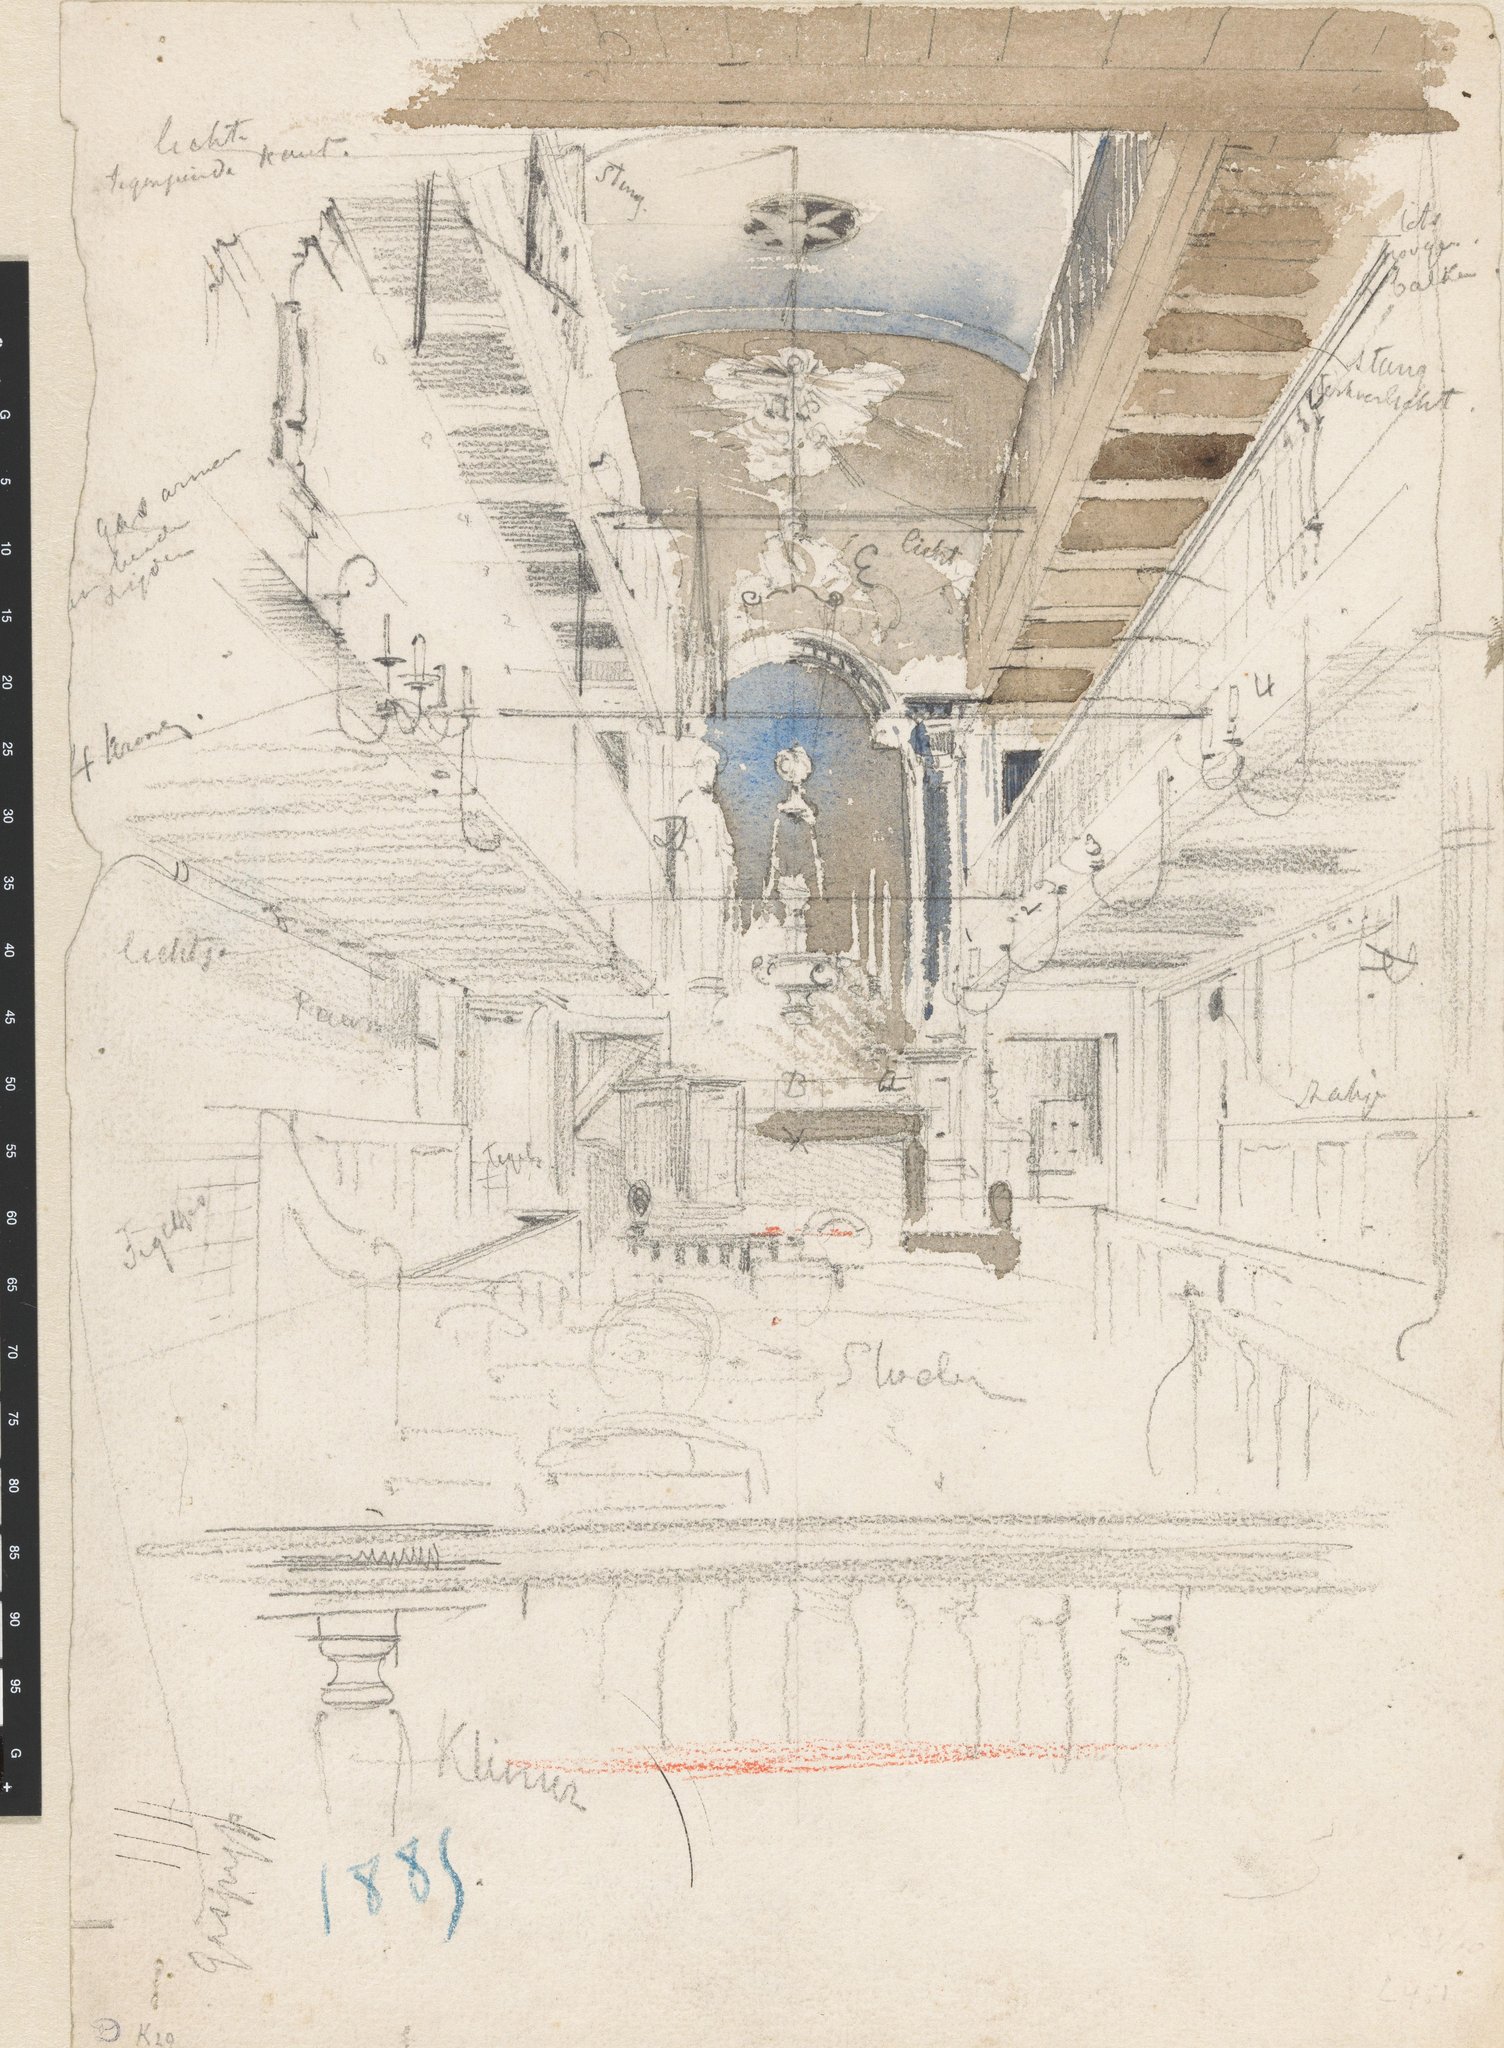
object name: drawing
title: Kerkinterieur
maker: Anonymous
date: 1885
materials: paper, pencil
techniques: brush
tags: interior of church